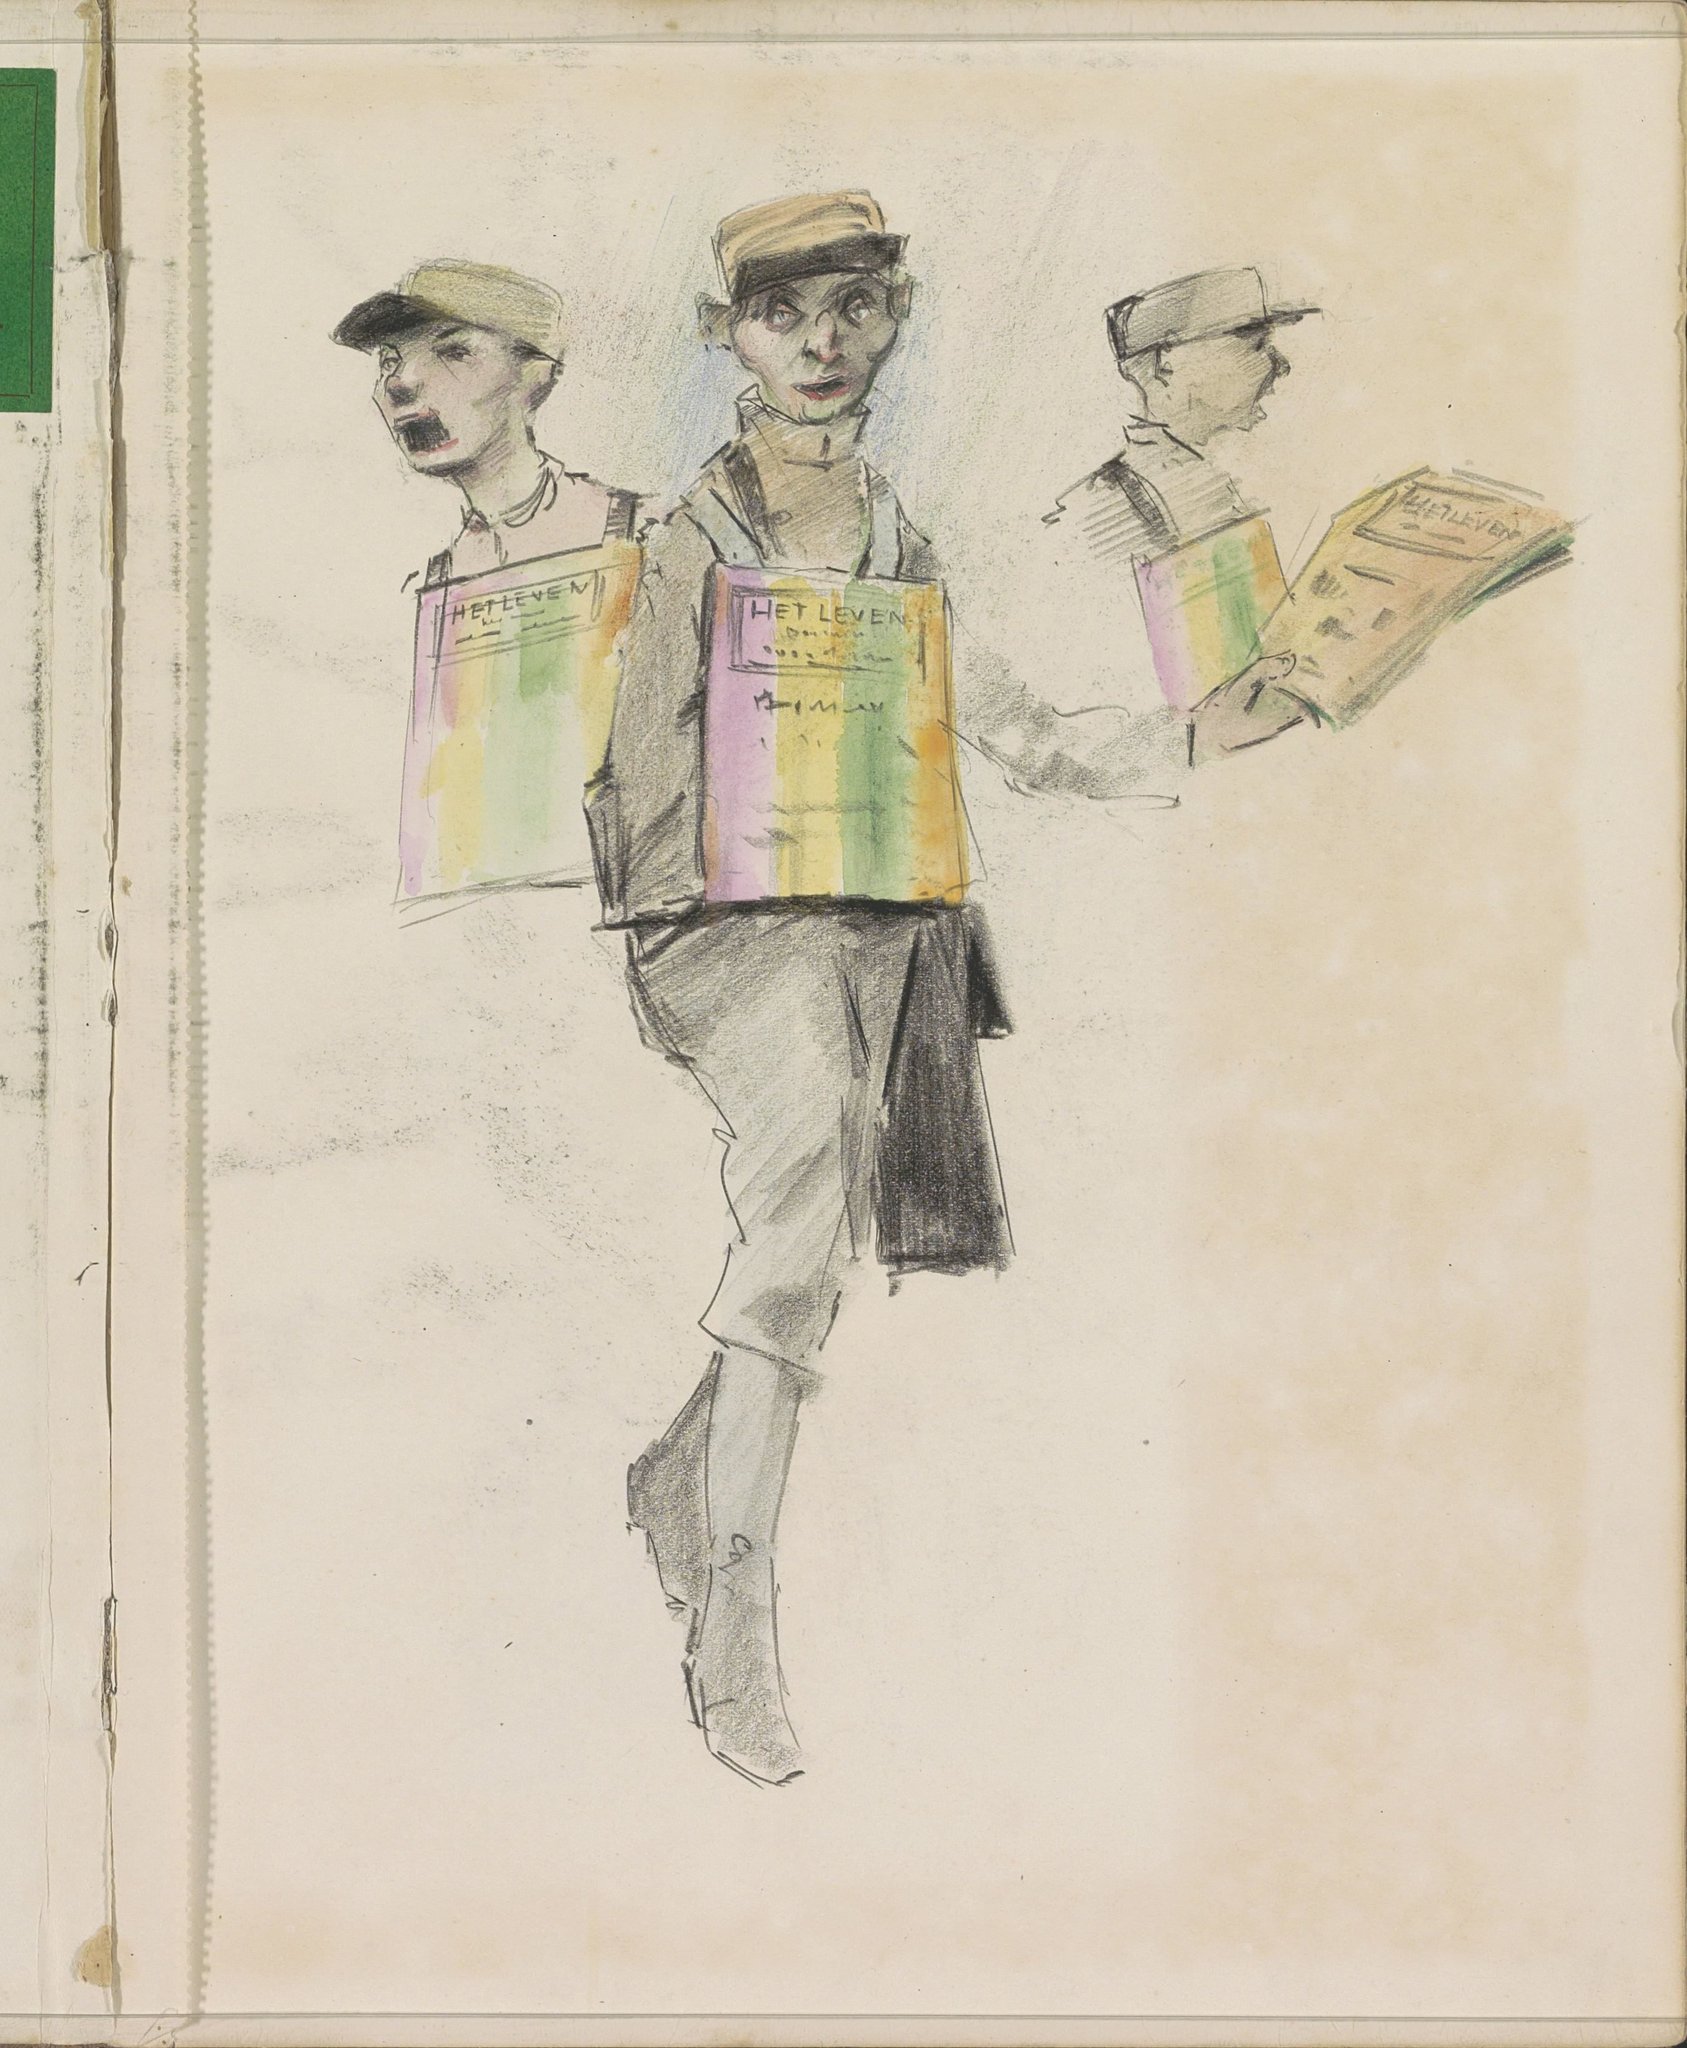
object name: sketchbook leaf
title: Verkoper van Amsterdams weekblad 'Het Leven'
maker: otto verhagen (i)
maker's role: draughtsman, print maker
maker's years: 1885-1951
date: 1917-1919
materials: chalk, paper, pencil, watercolor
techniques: brush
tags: merchant, salesman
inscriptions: annotation: ‘HET LEVEN/ HET LEVEN/ HET LEVEN’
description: De jongen draagt een pet en tas en heeft een tuig met op de voorzijde de omslag van het weekblad op zijn borst. Pagina 1 uit een schetsboek met 28 bladen.